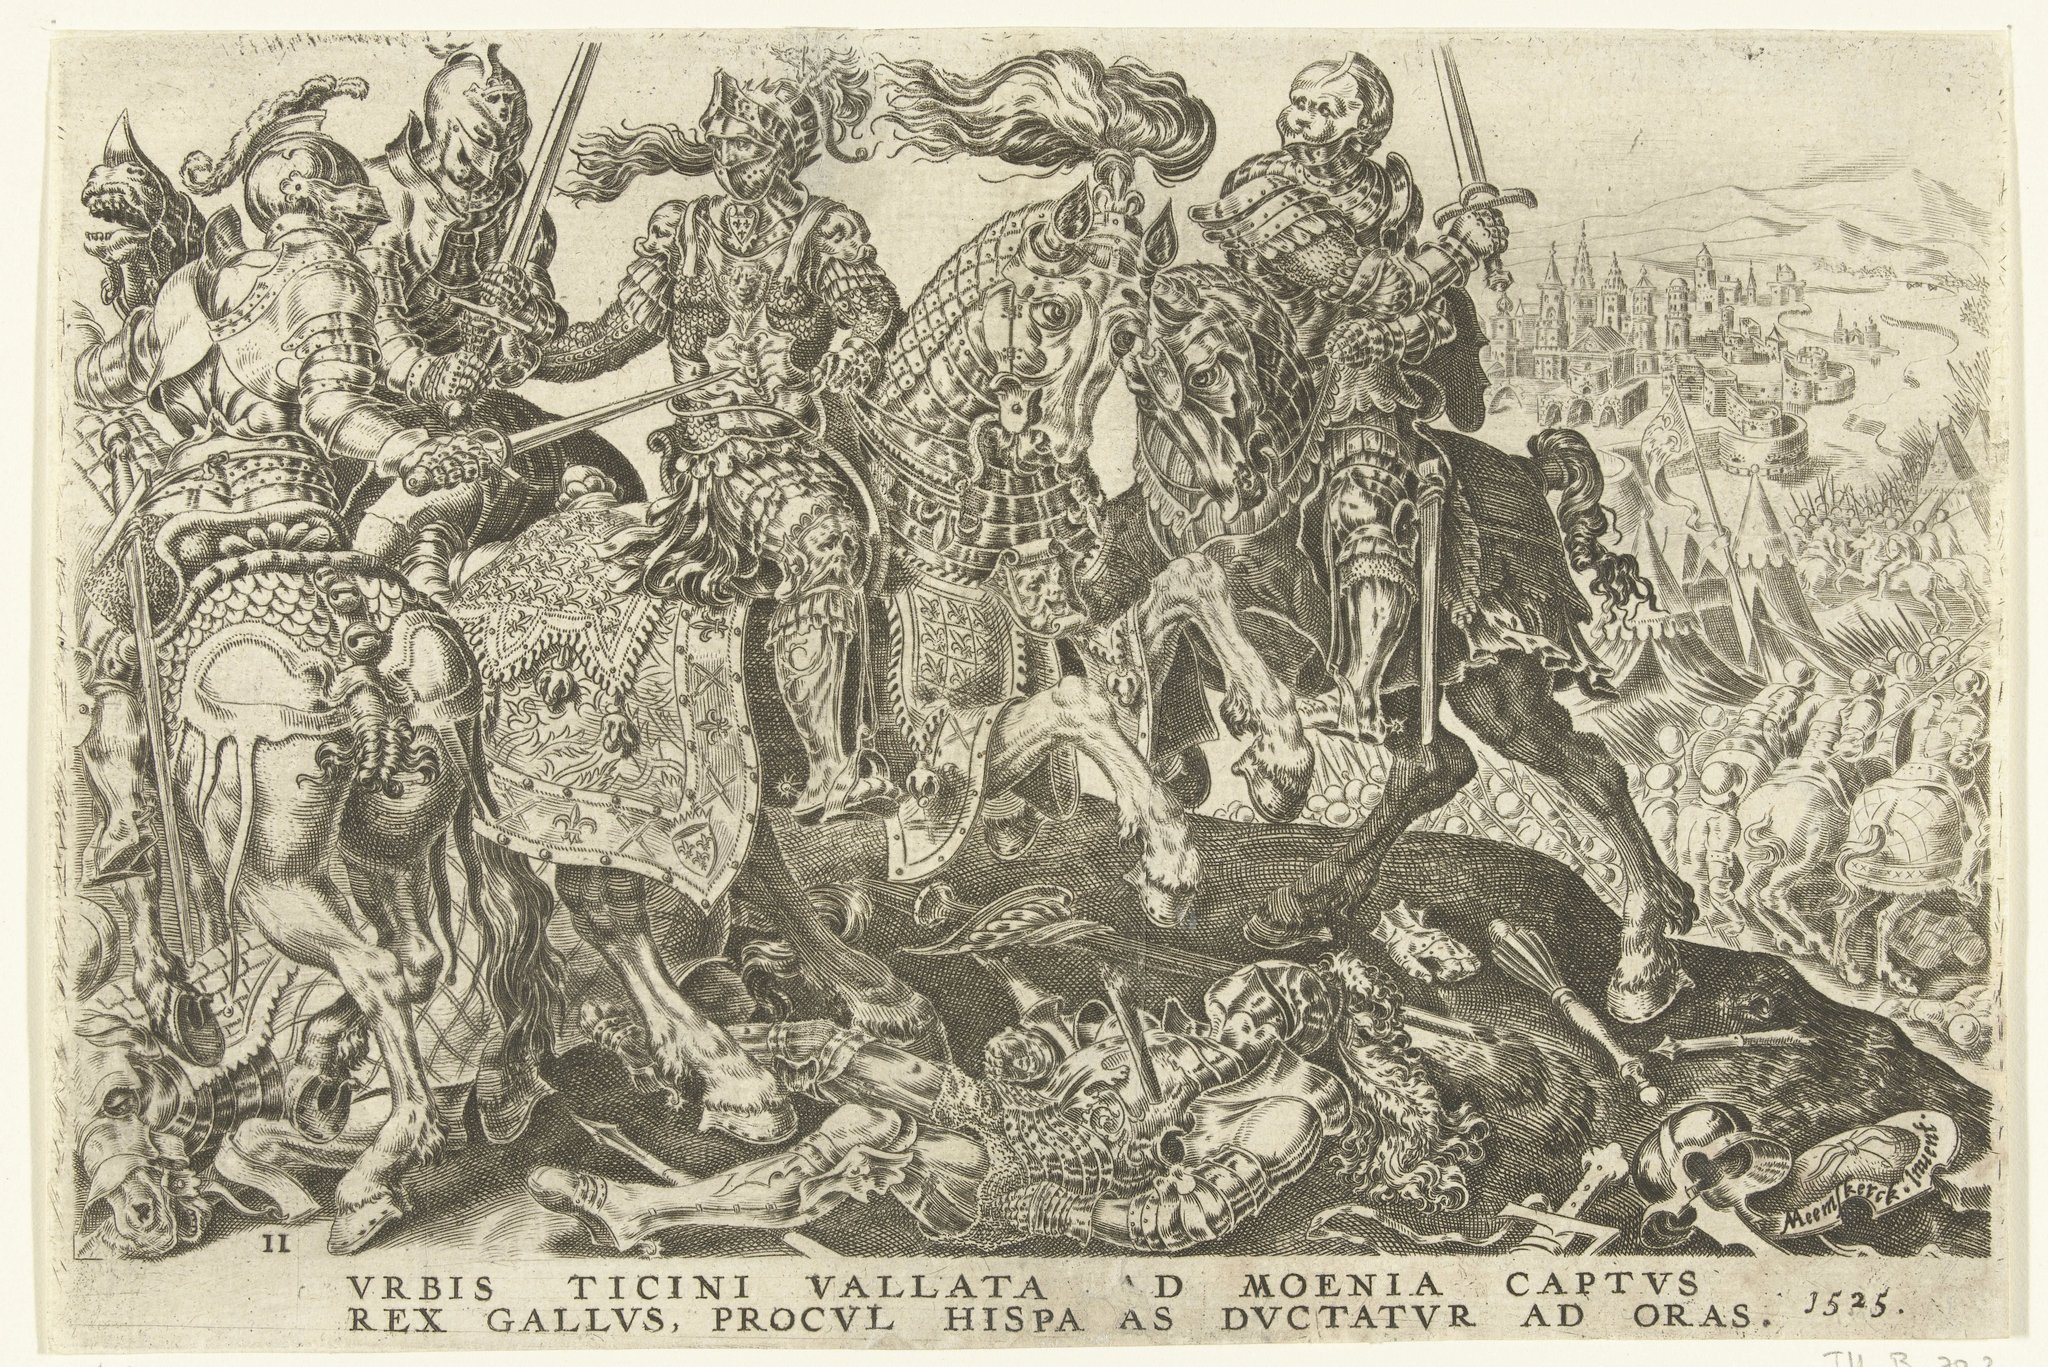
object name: print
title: Divi Caroli. V. imp. opt. max. victoriae, ex multis praecipuae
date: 1555-1556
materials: paper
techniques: engraving, etching, letterpress printing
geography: haarlem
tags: frans i van valois-angoulême (koning van frankrijk), ghent, charles v (holy roman emperor and king of spain), battle (+ cavalry, horsemen)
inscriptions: collector's mark: Lugt 2228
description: De gevangenname van Frans I, koning van Frankrijk, tijdens de slag bij Pavia in 1525. De koning te paard wordt omringd door drie ridders, eveneens te paard. Op de voorgrond ligt het lichaam van een verslagen ridder. Op de achtergrondtenten en legers met in de verte de stad Pavia. De prent heeft een Latijns onderschrift en maakt deel uit van een twaalfdelige serie over de overwinningen van Karel V.